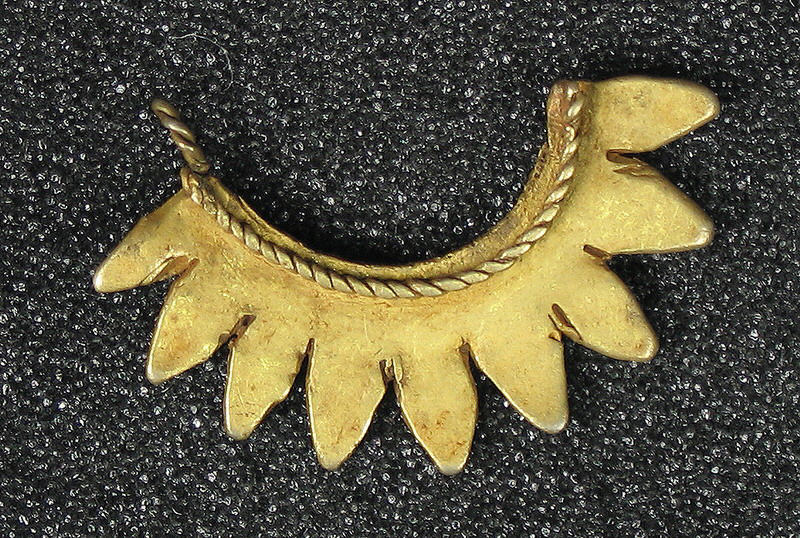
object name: ornament fragment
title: Fragment of an Ornament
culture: indonesian, central java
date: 701-1200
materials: gold